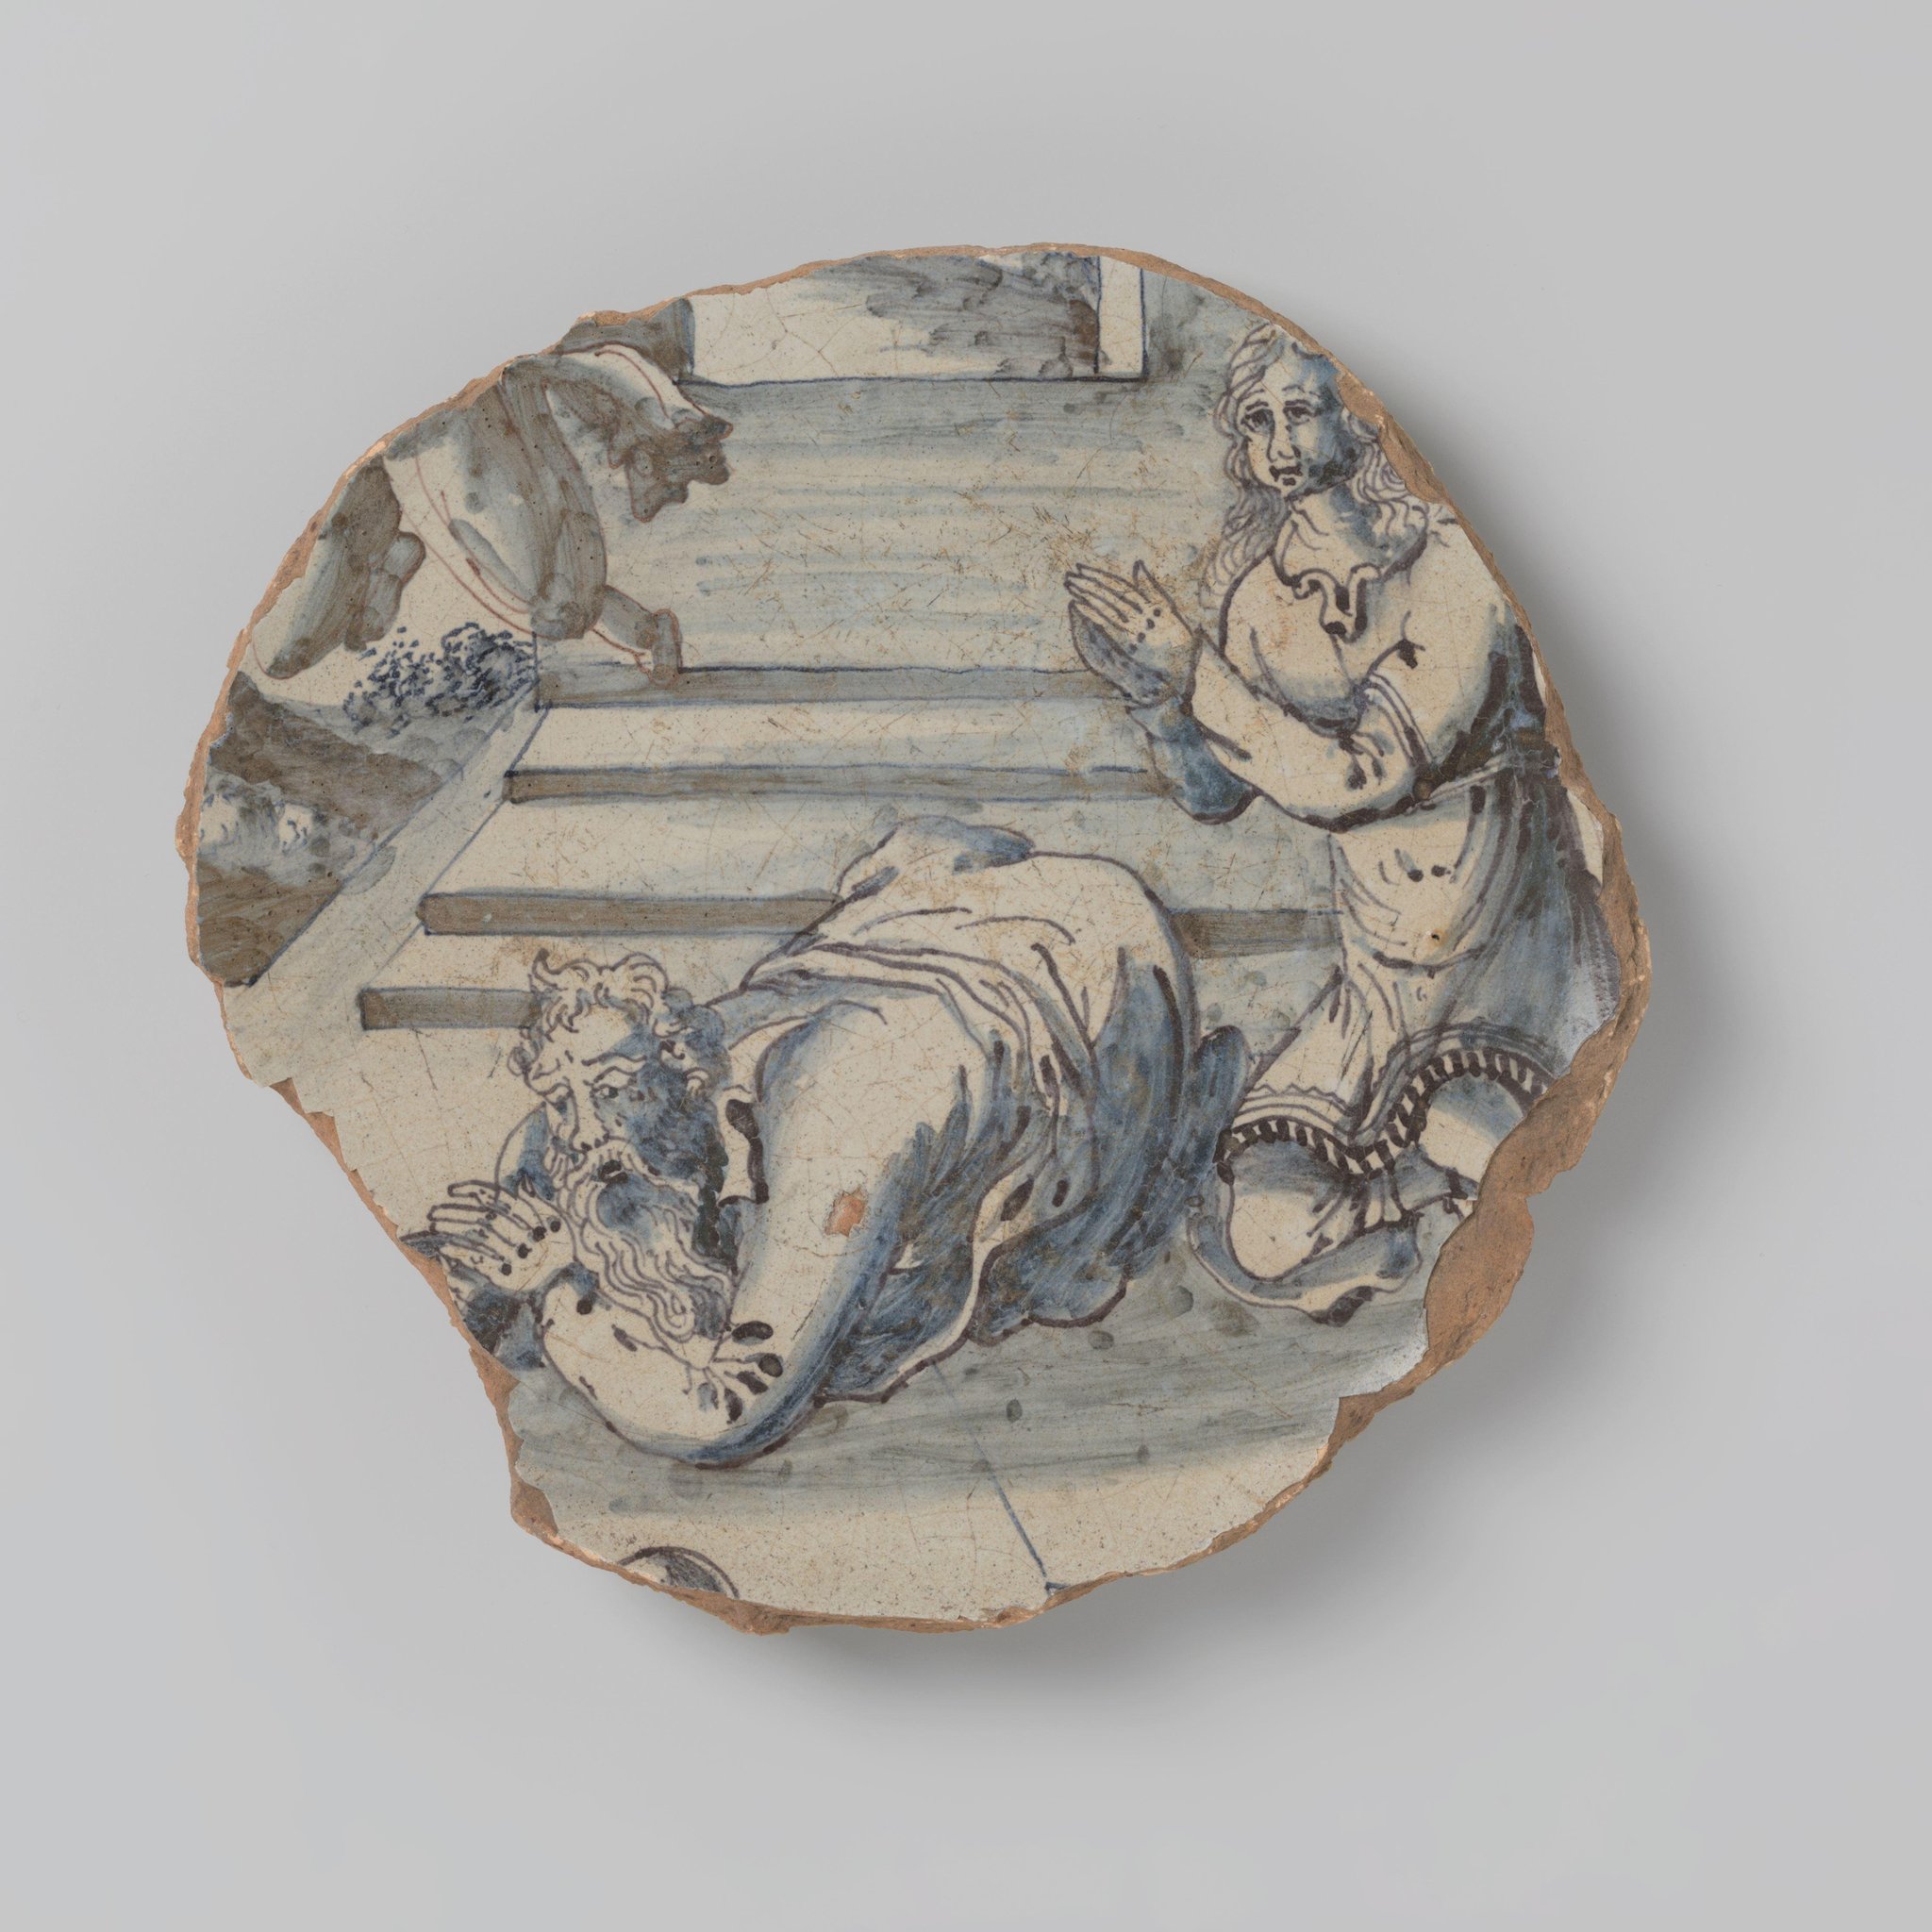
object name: sherd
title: Schotelscherf van aardewerk met tekening van drie figuren bij een trap, in onderglazuur blauw, mogelijk het offer van Manoah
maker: Anonymous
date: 1500-1799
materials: earthenware, glaze